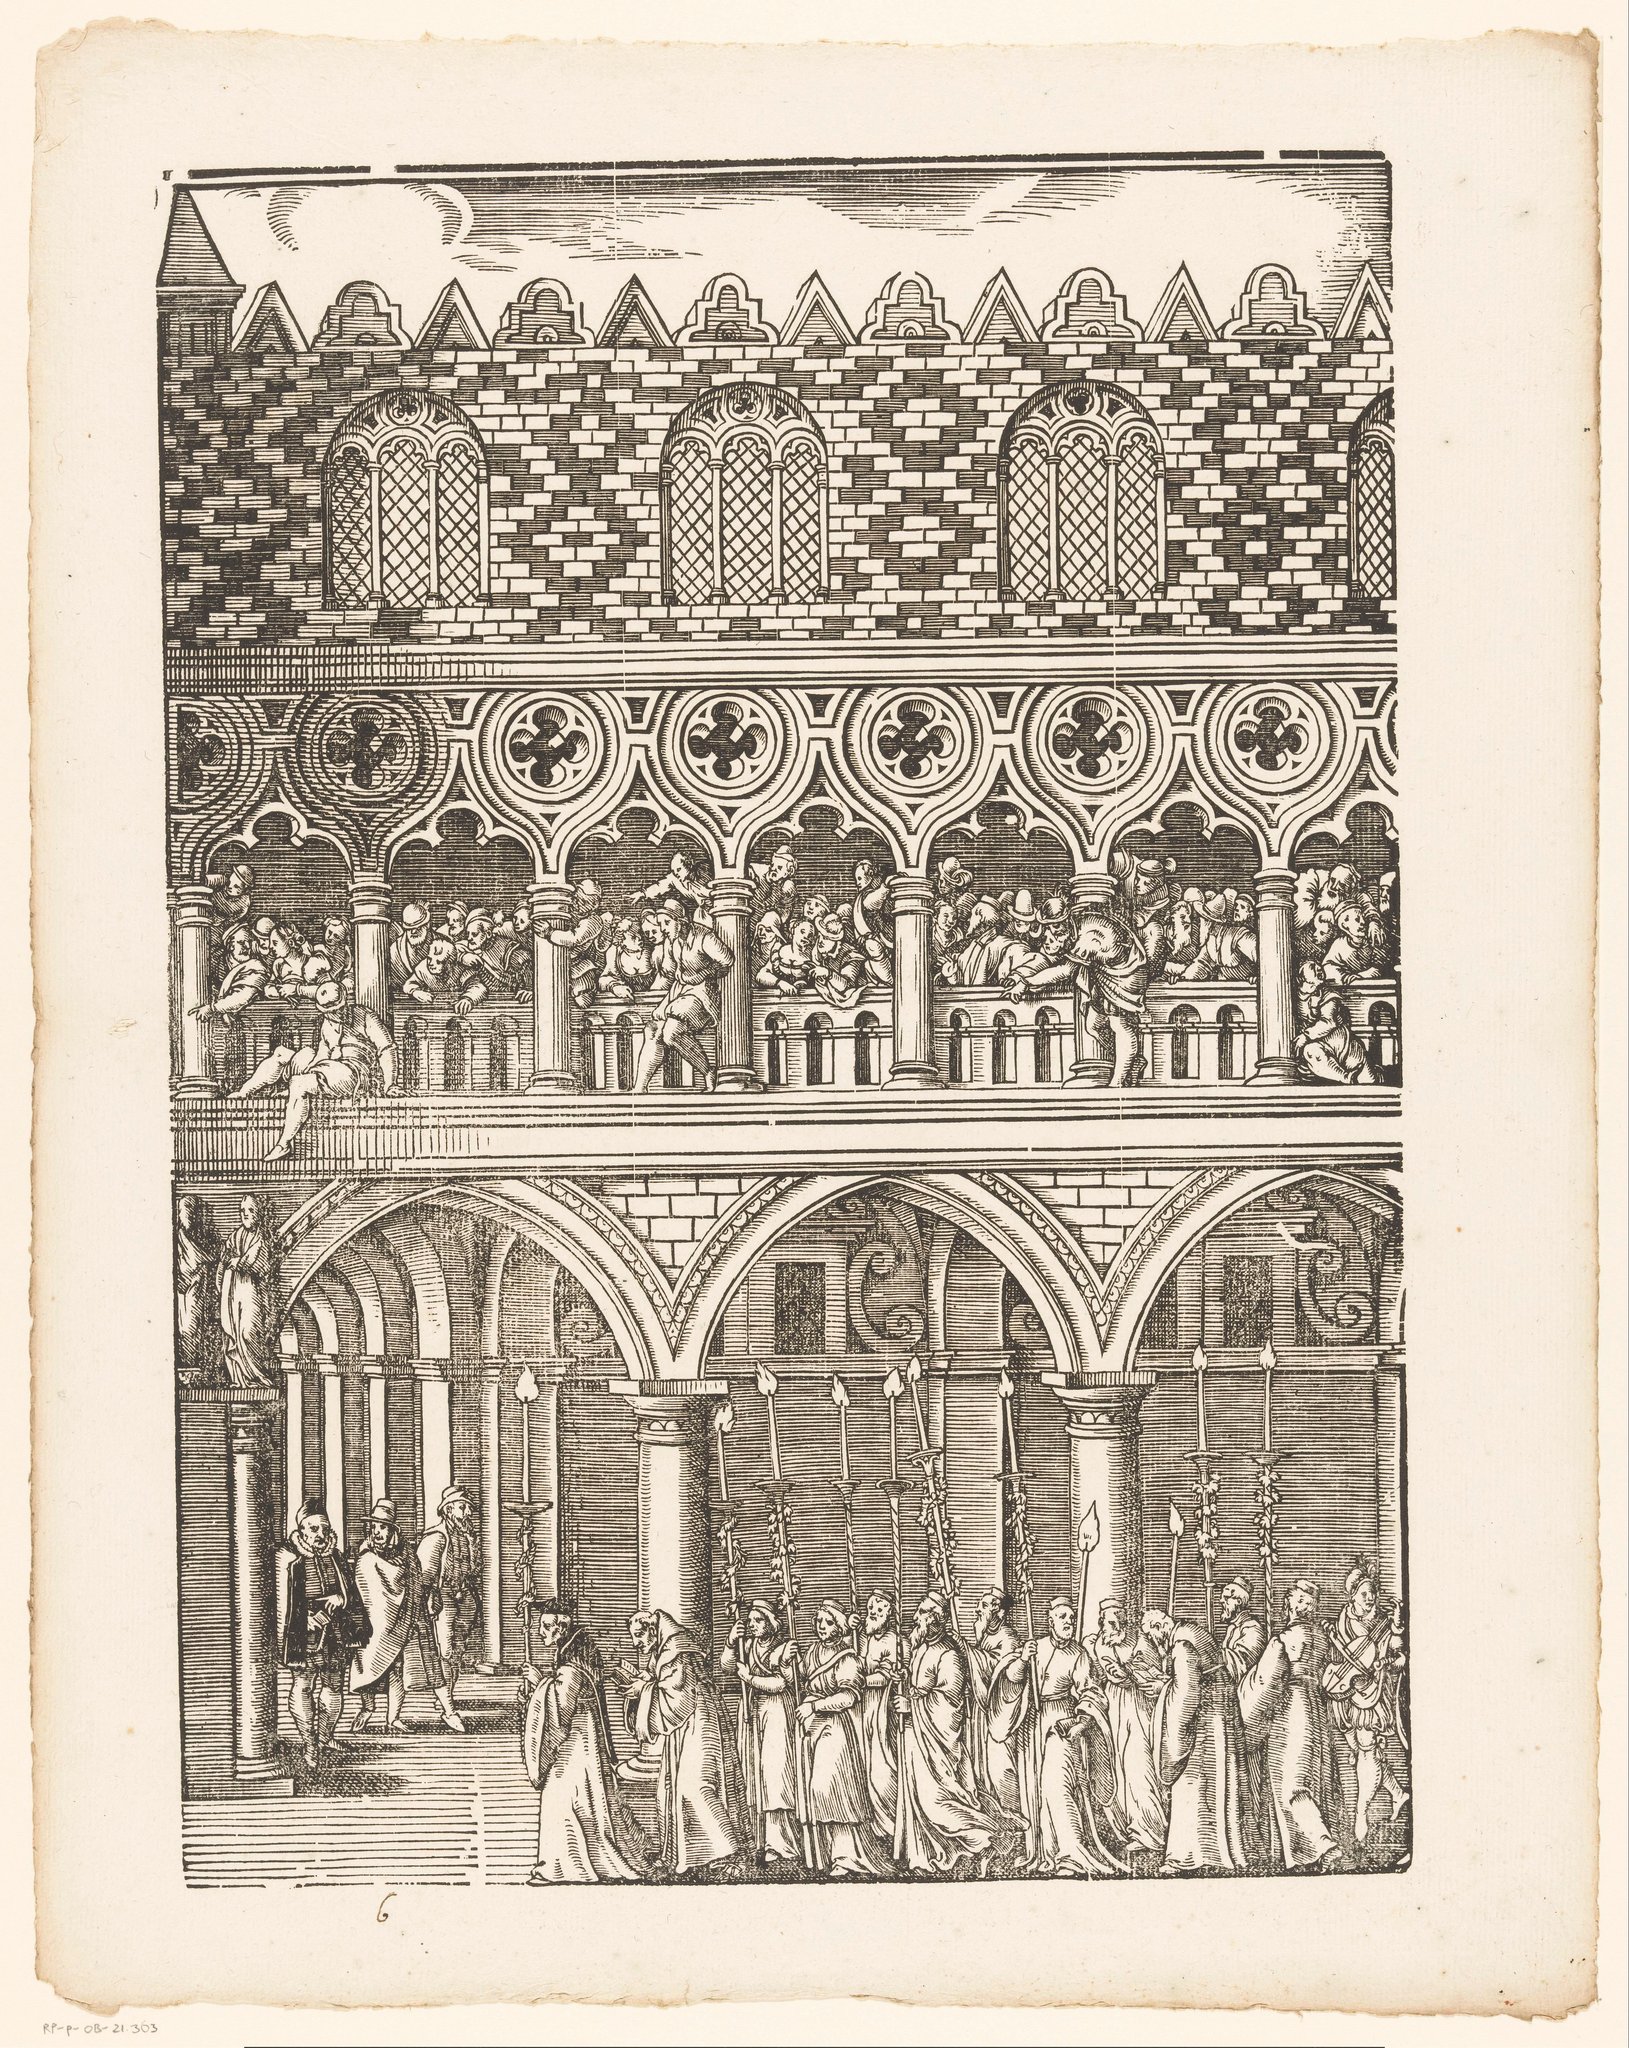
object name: print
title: Ankunfft Und herkommen der weitberümbten herrlichen Statt Venedig Sambt derselben gewaltigen Herrschafft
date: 1679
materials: paper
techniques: woodcut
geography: nuremberg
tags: city-view in general; 'veduta', procession ~ christian religion, gondola, venice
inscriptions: number: ‘6’, collector's mark: Lugt 240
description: Zesde gedeelte van een grote voorstelling van de Festa della Sensa. De voorstelling is gedrukt van veertien blokken, de titel van vijf blokken en het onderschrift bestaat uit vijf delen van elk drie kolommen Duits tekst. In de collectie Rijksmuseum bevinden zich twee complete exemplaren inclusief titel en onderschrift. De veertien blokken die samen de voorstelling vormen zijn in de titels met de klok mee vanaf linksboven genummerd.